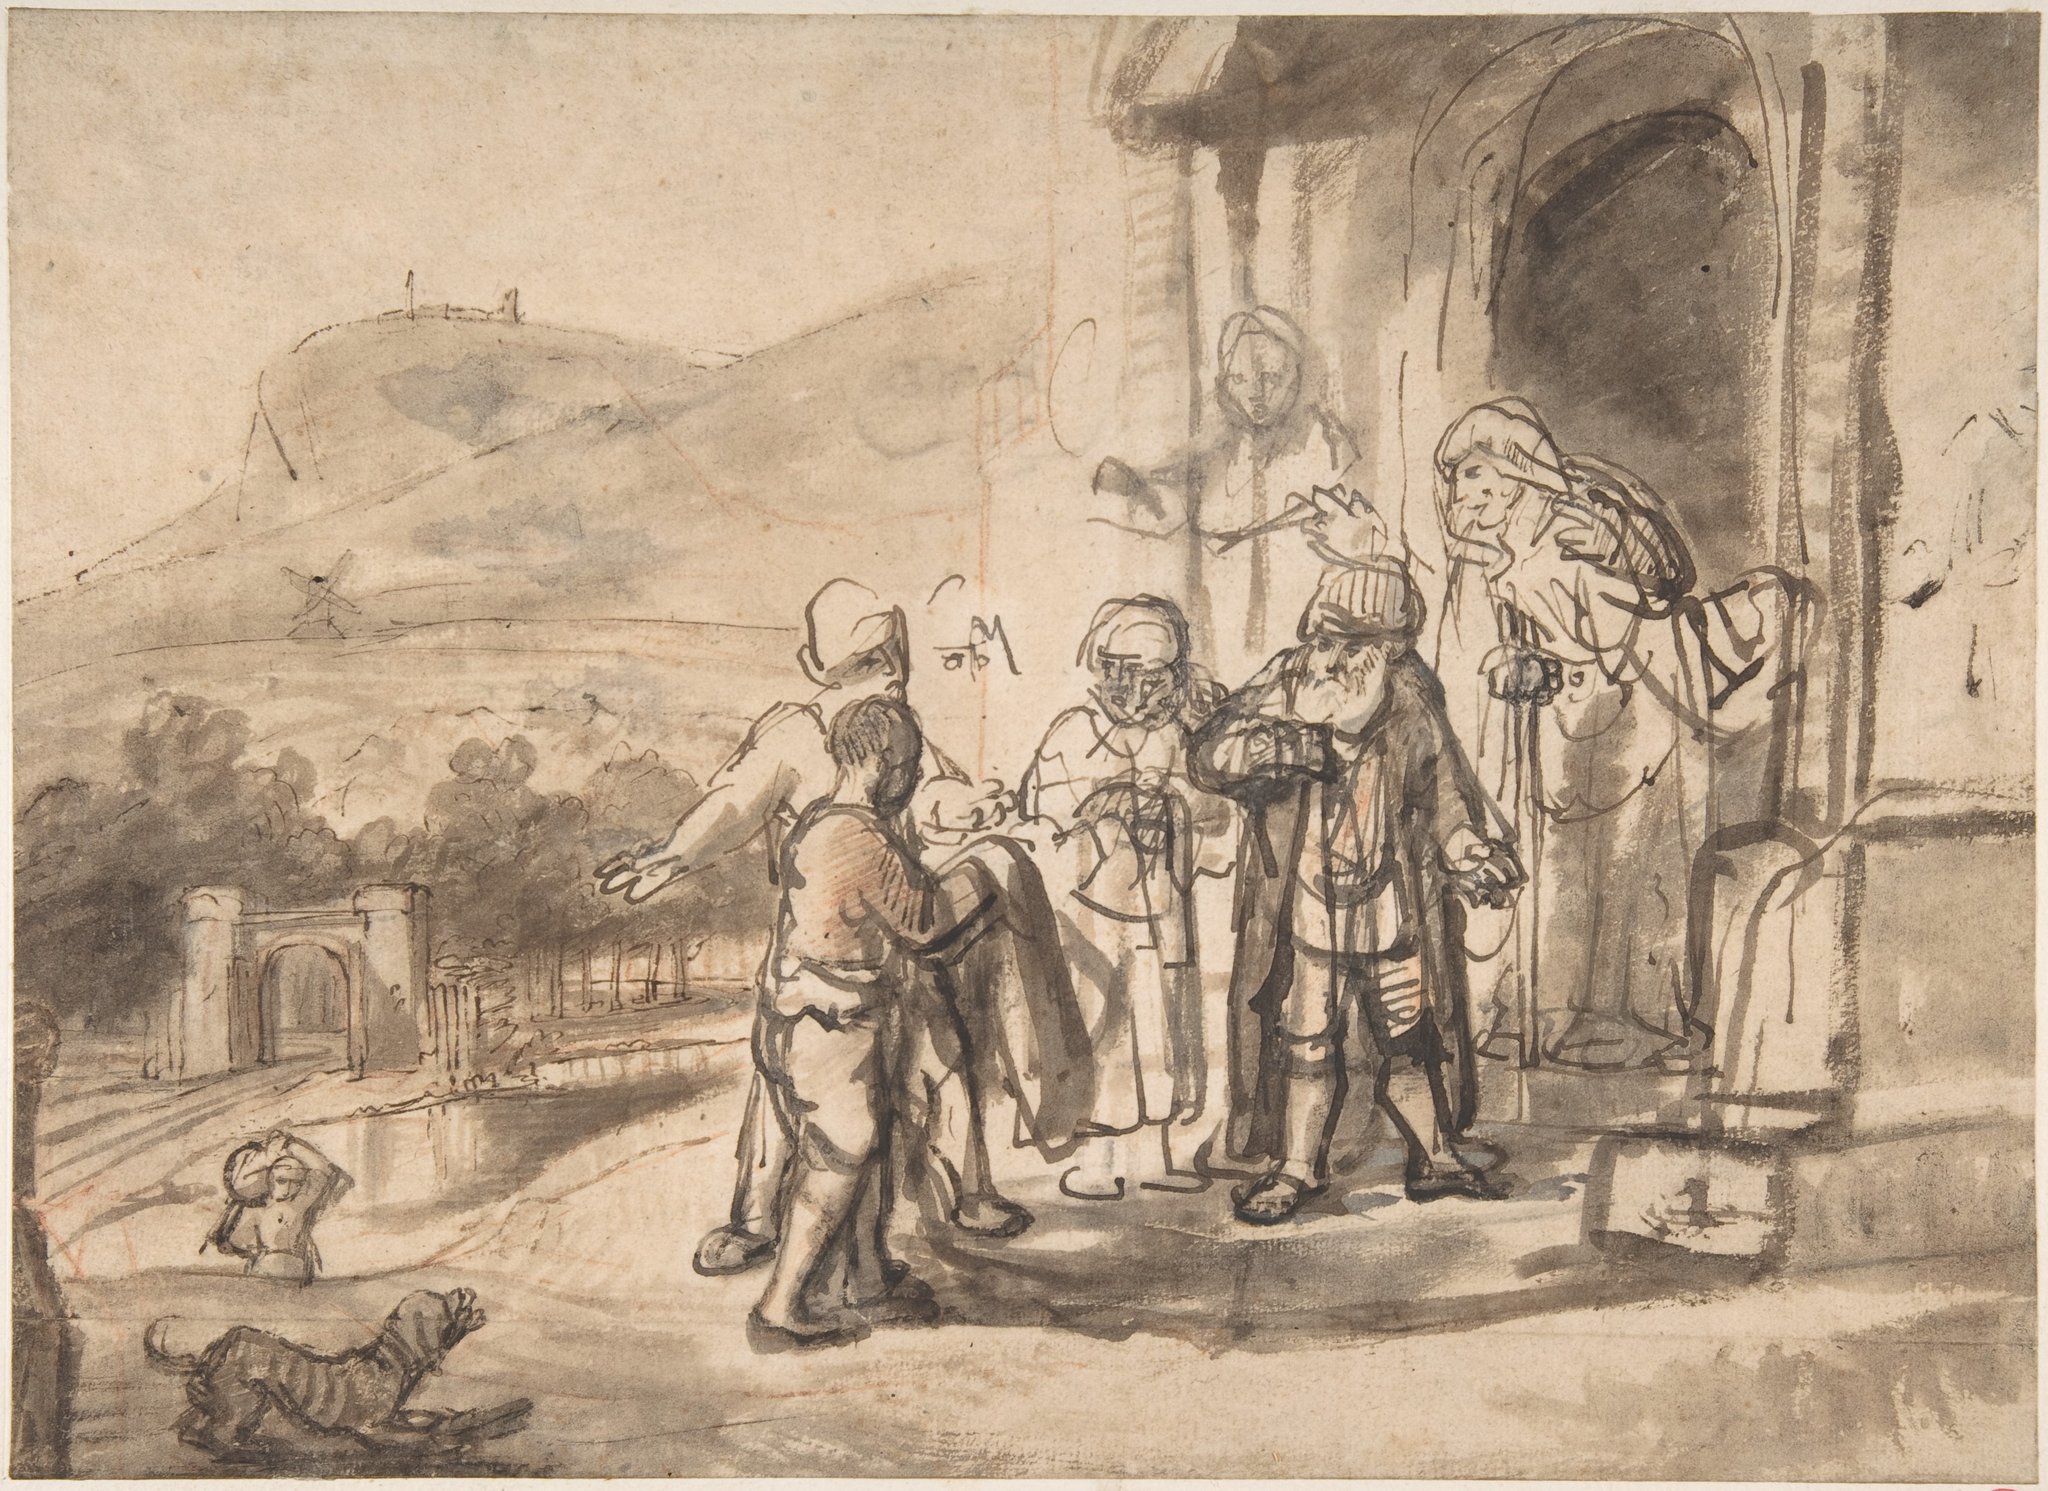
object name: drawing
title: Jacob Receiving Joseph's Blood-Stained Cloak (recto); Study of a Bearded Man and The Sacrifice of Isaac (verso)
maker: nicolaes maes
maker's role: artist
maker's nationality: dutch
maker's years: 1634-1693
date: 1653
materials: chalk, ink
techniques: brush, pen, wash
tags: gates,men,women,dogs